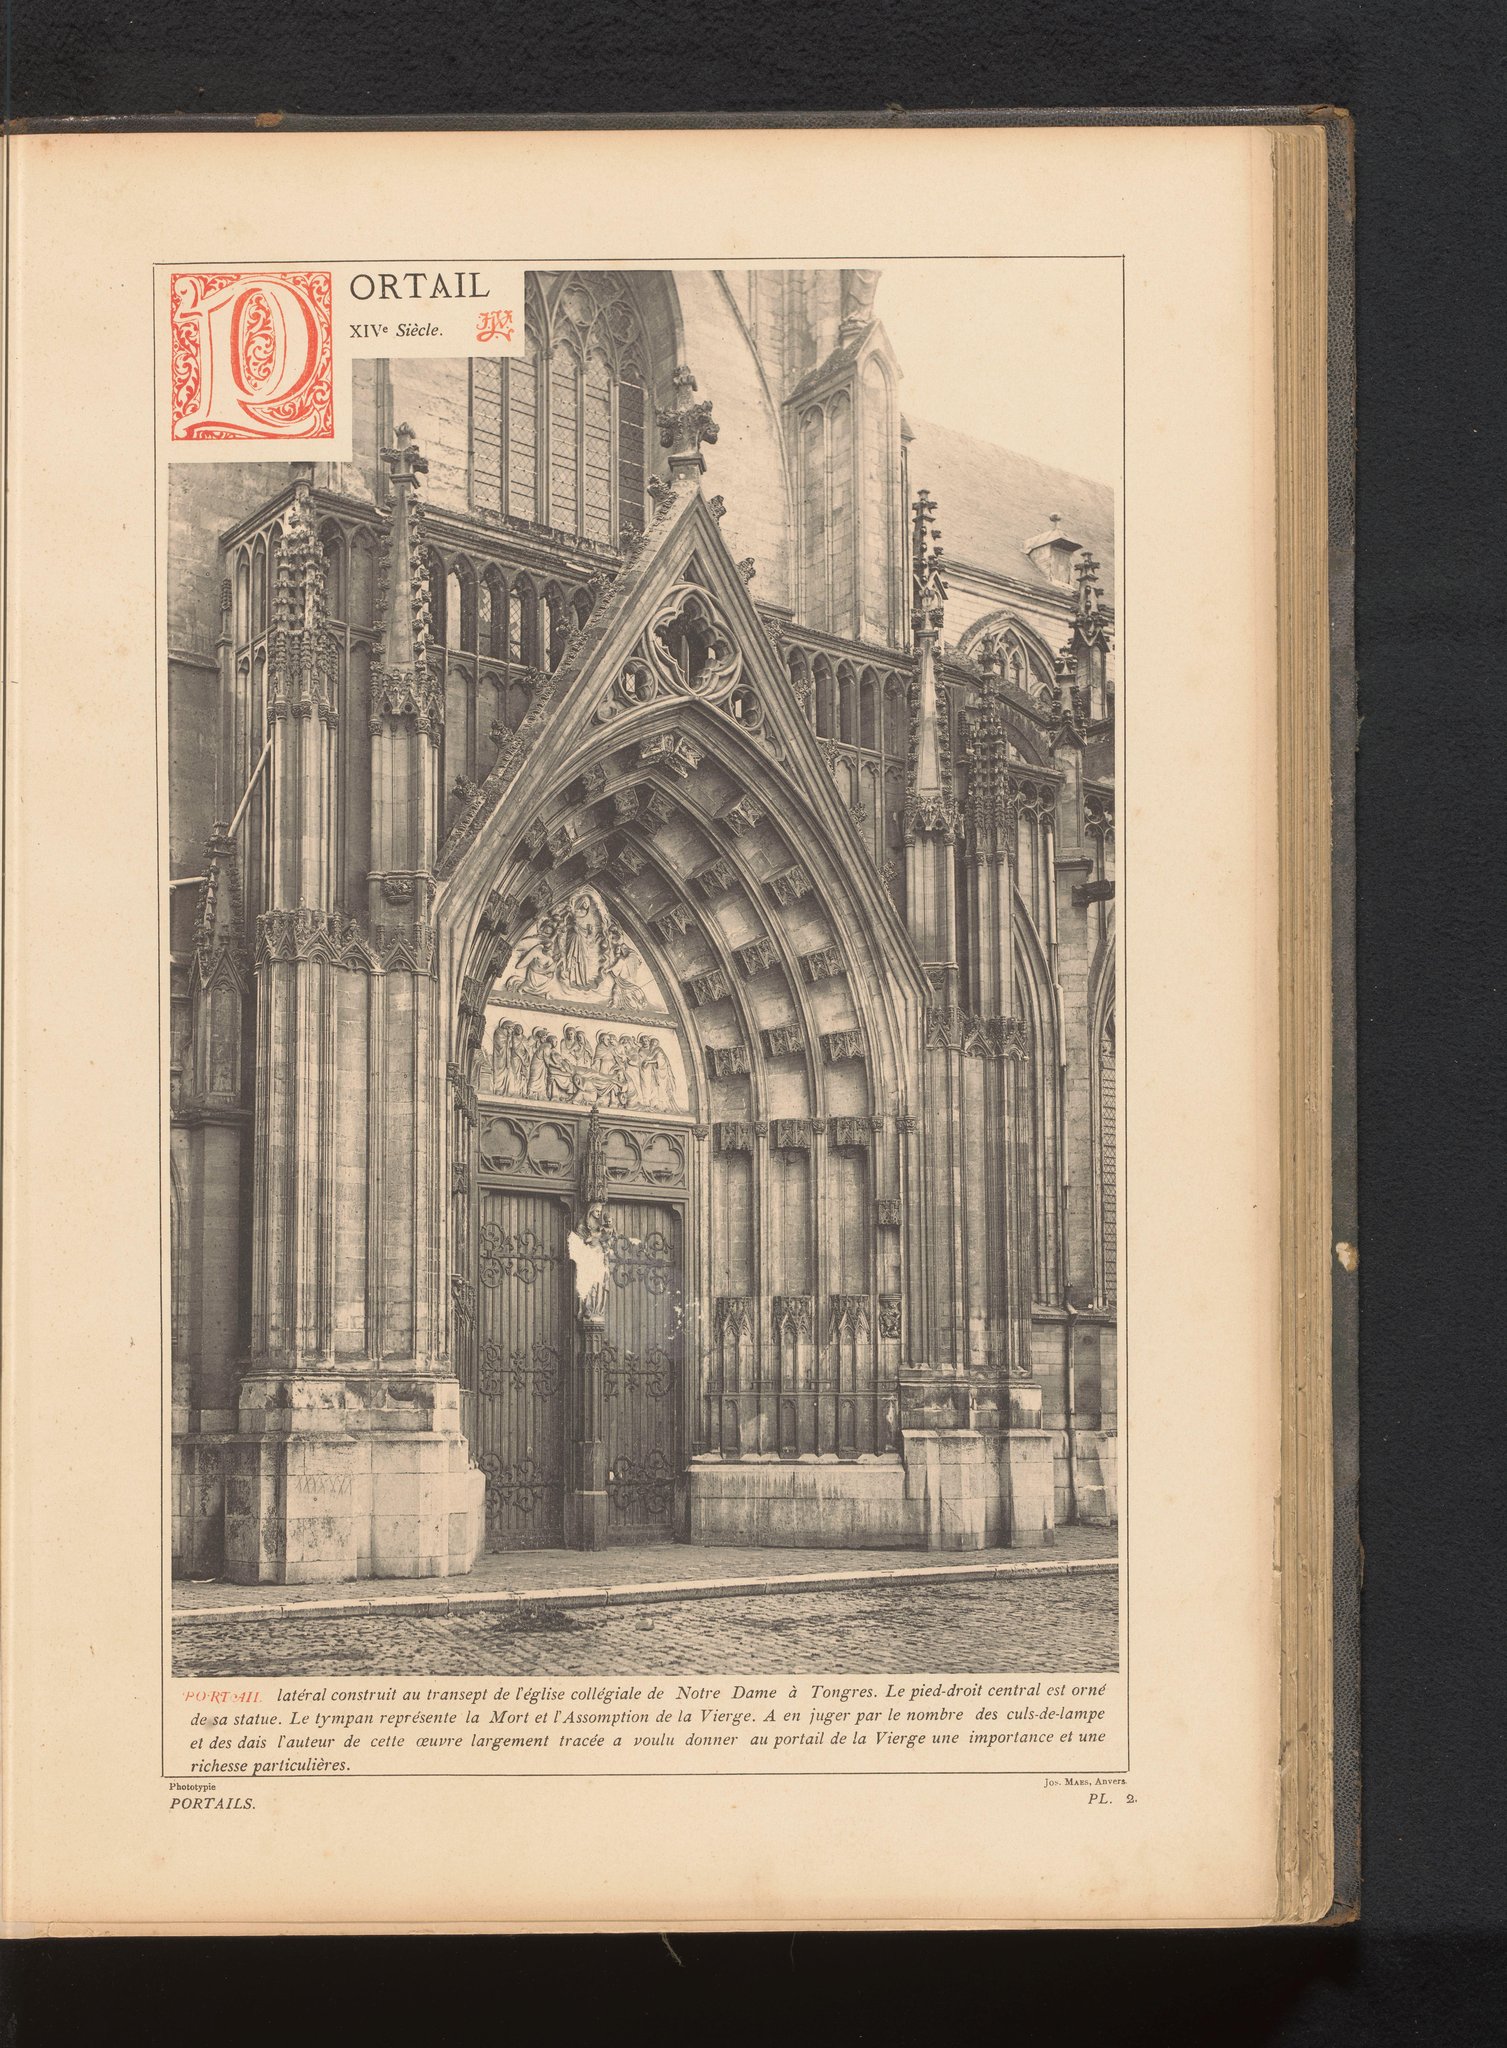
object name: page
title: Portail, XIVe Siècle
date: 1881-1889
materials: paper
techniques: photograph, photolithography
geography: antwerp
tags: parts of church exterior and annexes: portal, parts of church interior: transept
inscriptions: inscription: ‘PORTAILS. PL. 2.’, inscription: ‘PORTAIL latéral construit (...)’, monogram: ‘JJvY’